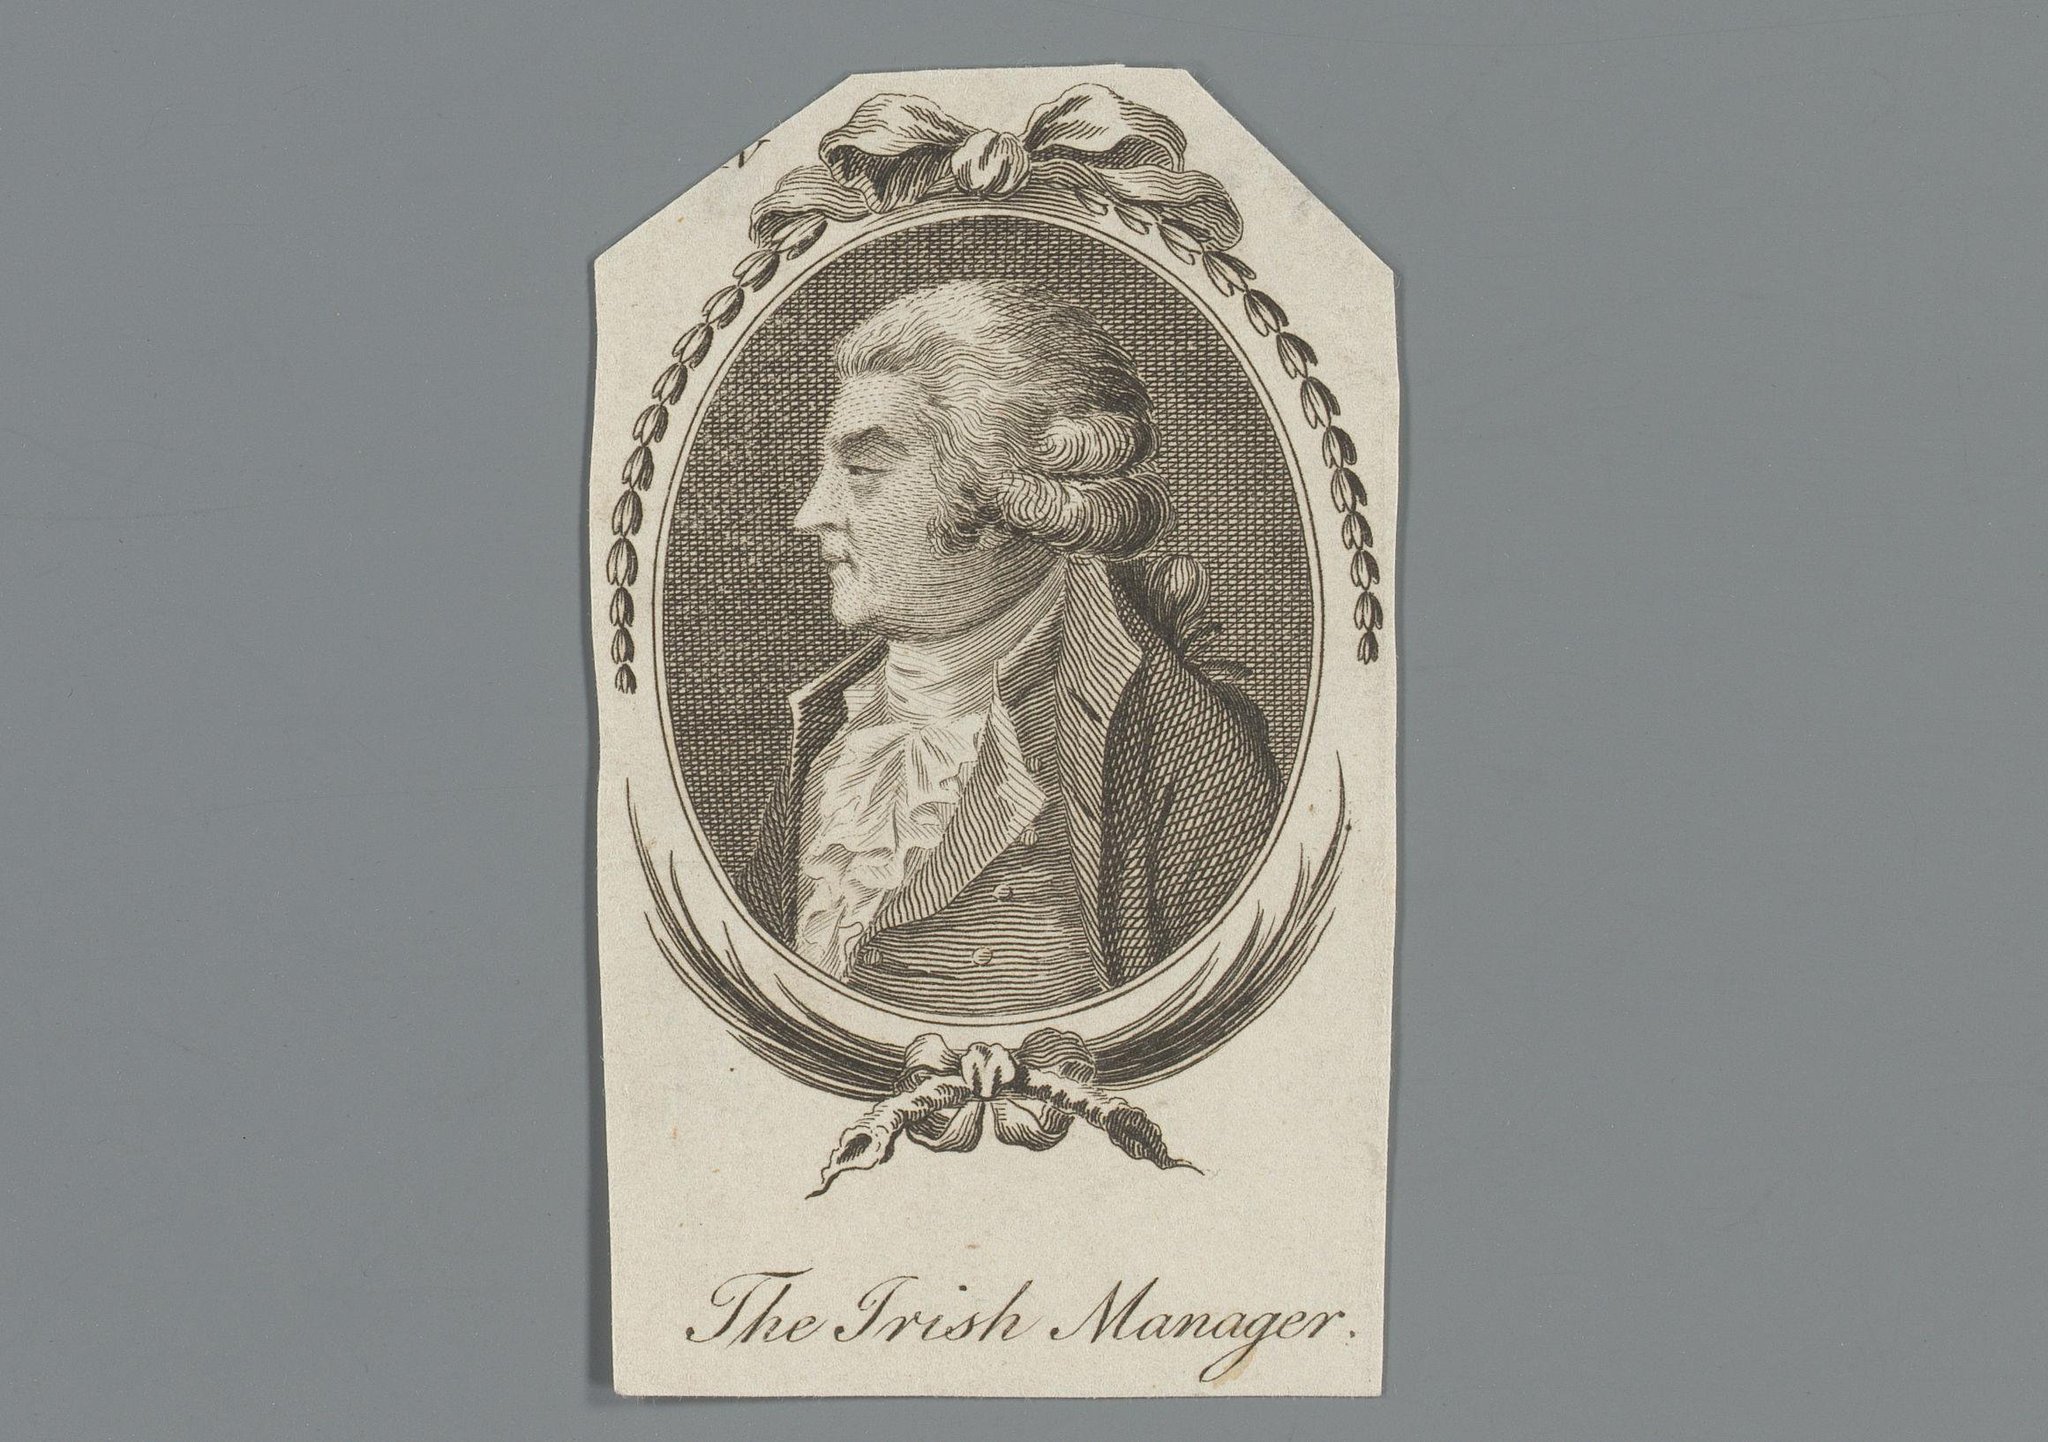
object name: print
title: The Irish Manager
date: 1787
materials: paper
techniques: etching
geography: london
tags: historical persons, portrait of actor, actress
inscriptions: collector's mark: Lugt 2228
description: Prent waarschijnlijk uit: Town and Country Magazine 19 (1787), januari 1787.